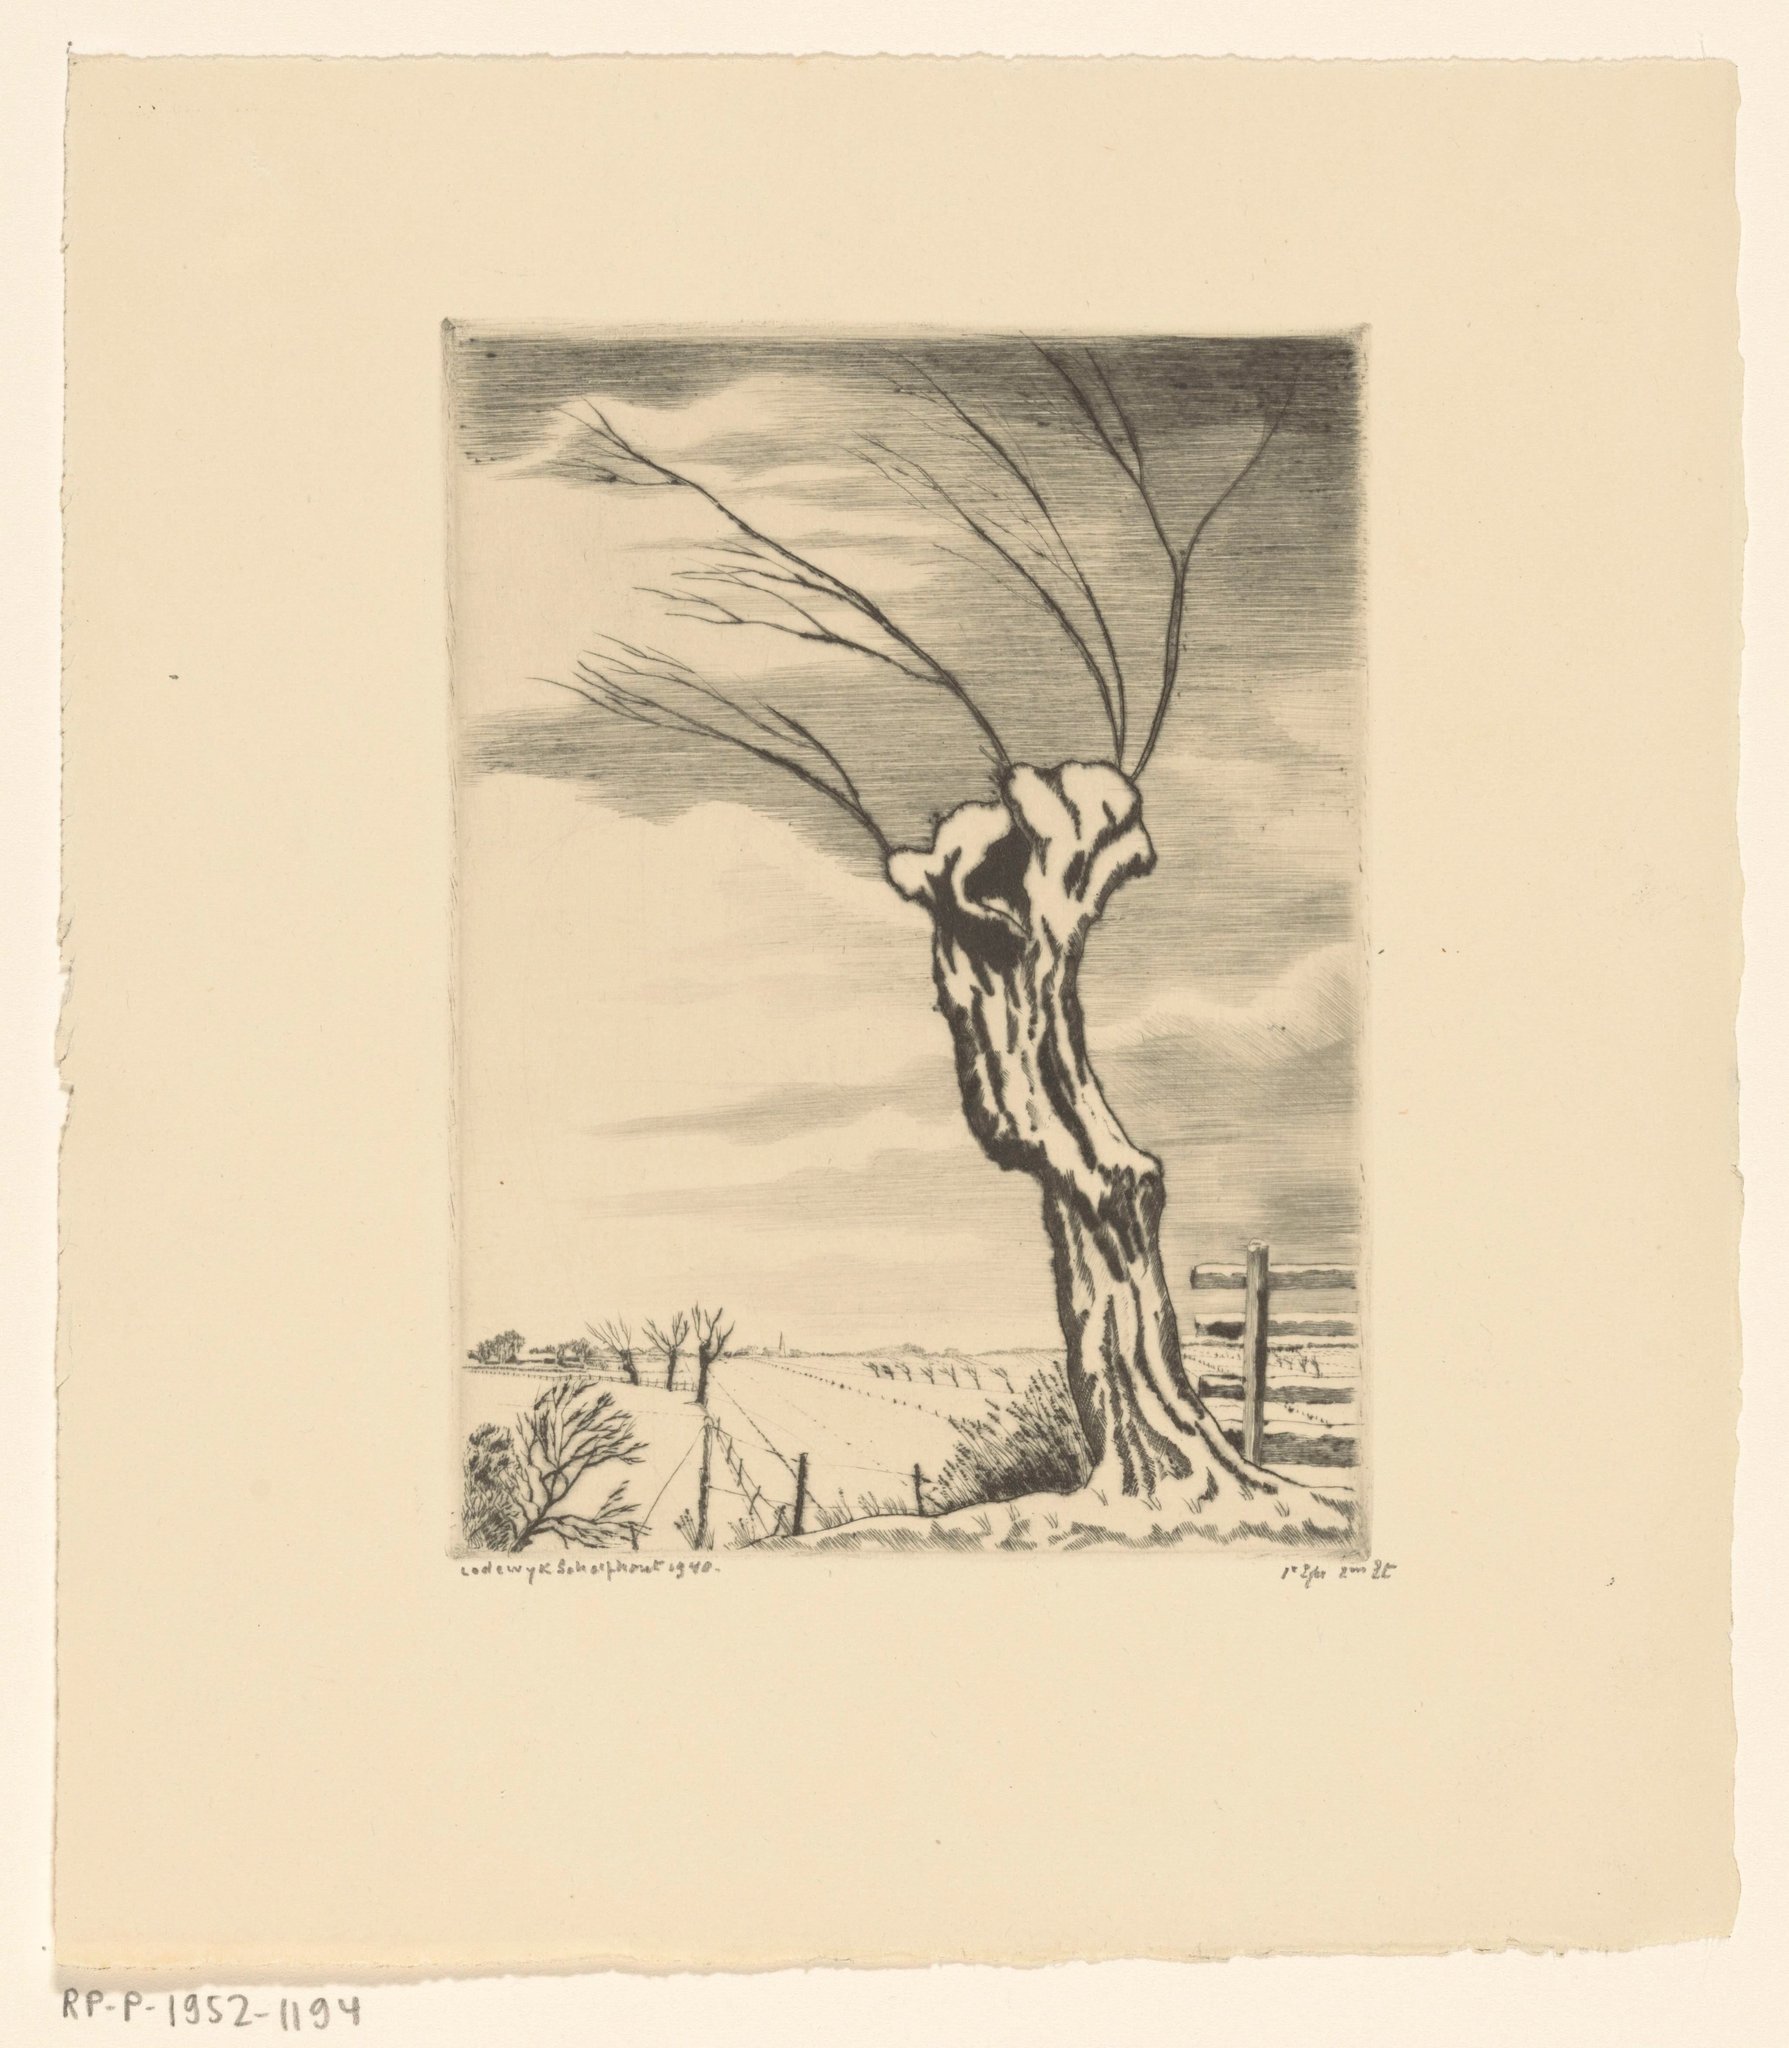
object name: print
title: Le Saule II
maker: lodewijk schelfhout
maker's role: draughtsman, print maker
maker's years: 1881-1943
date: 1940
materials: paper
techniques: drypoint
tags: snow, trees: willow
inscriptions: collector's mark: Lugt 2228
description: Een knotwilg naast een hek in een besneeuwd landschap met akkers.